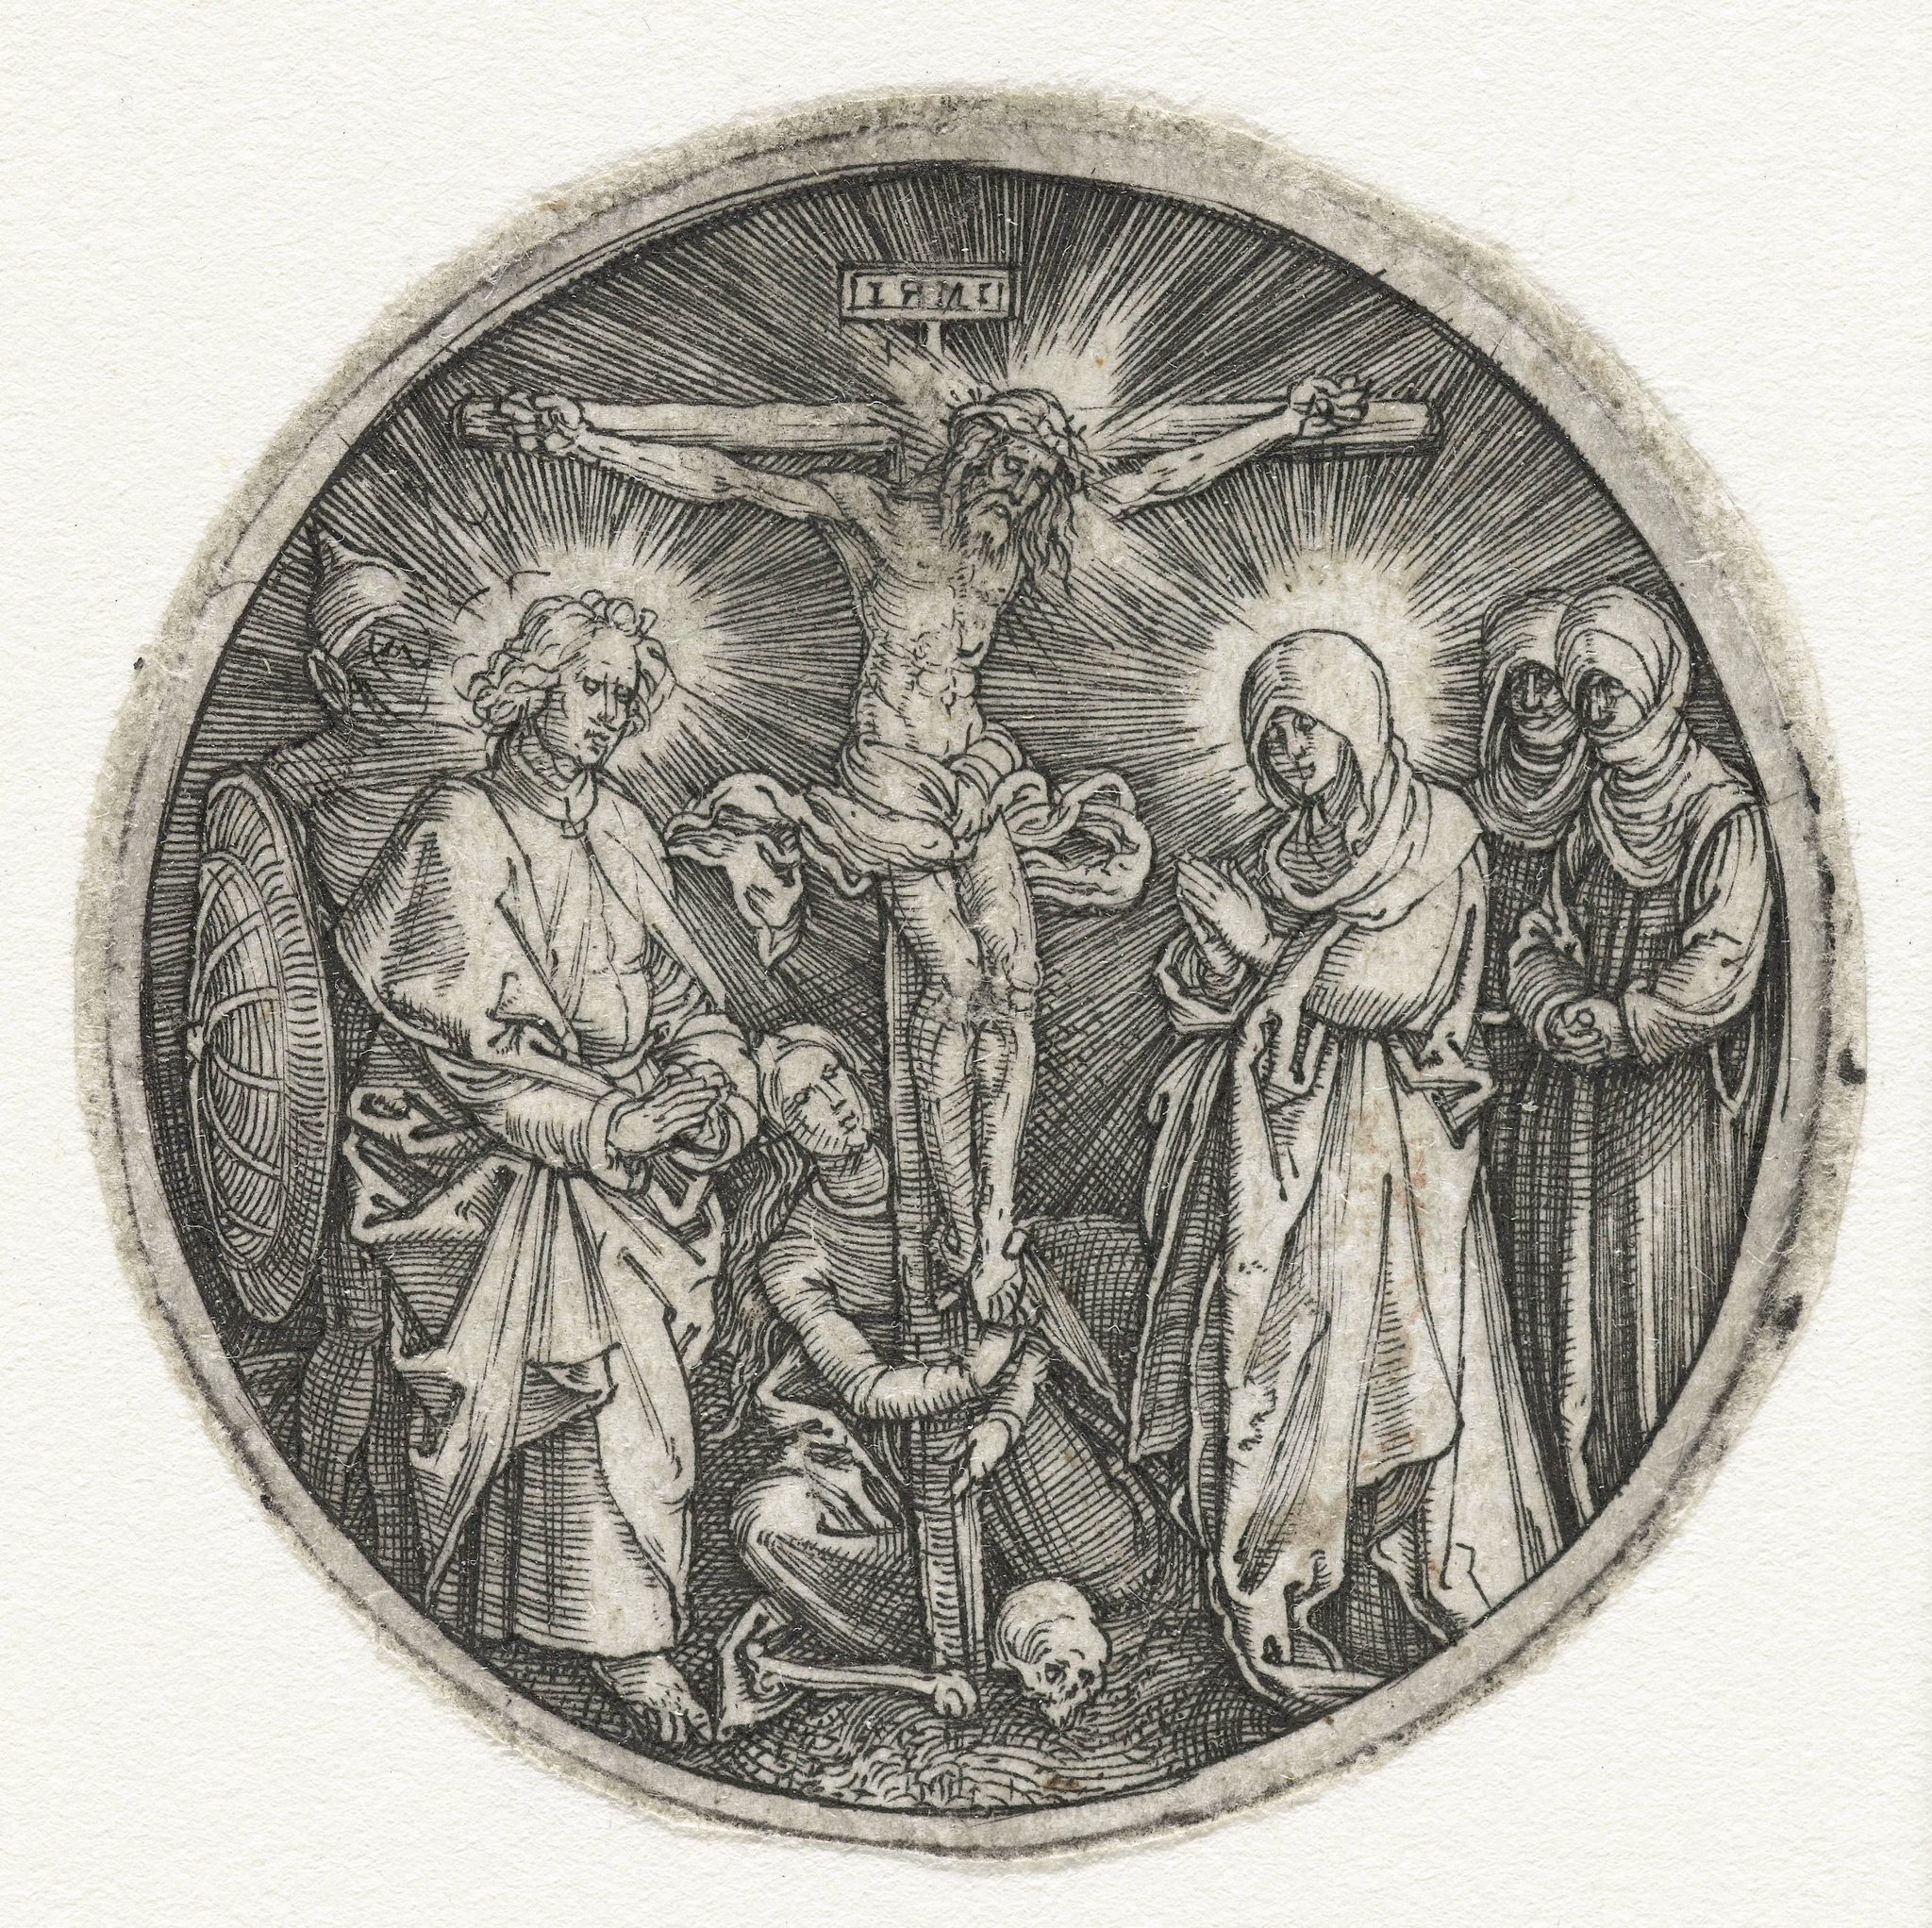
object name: print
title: De kleine kruisiging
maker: albrecht dürer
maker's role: draughtsman, painter, print maker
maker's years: 1471-1528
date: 1517-1521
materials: paper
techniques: engraving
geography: nuremberg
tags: crucified christ with mary, john, and mary magdalene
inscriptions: collector's mark: Lugt 2228a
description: Ronde voorstelling van Christus aan het kruis. Aan zijn rechterzijde staat Johannes de evangelist, aan zijn linkerzijde zijn moeder Maria met nog twee vrouwen. Aan de voet van het kruis zit Maria Magdalena.